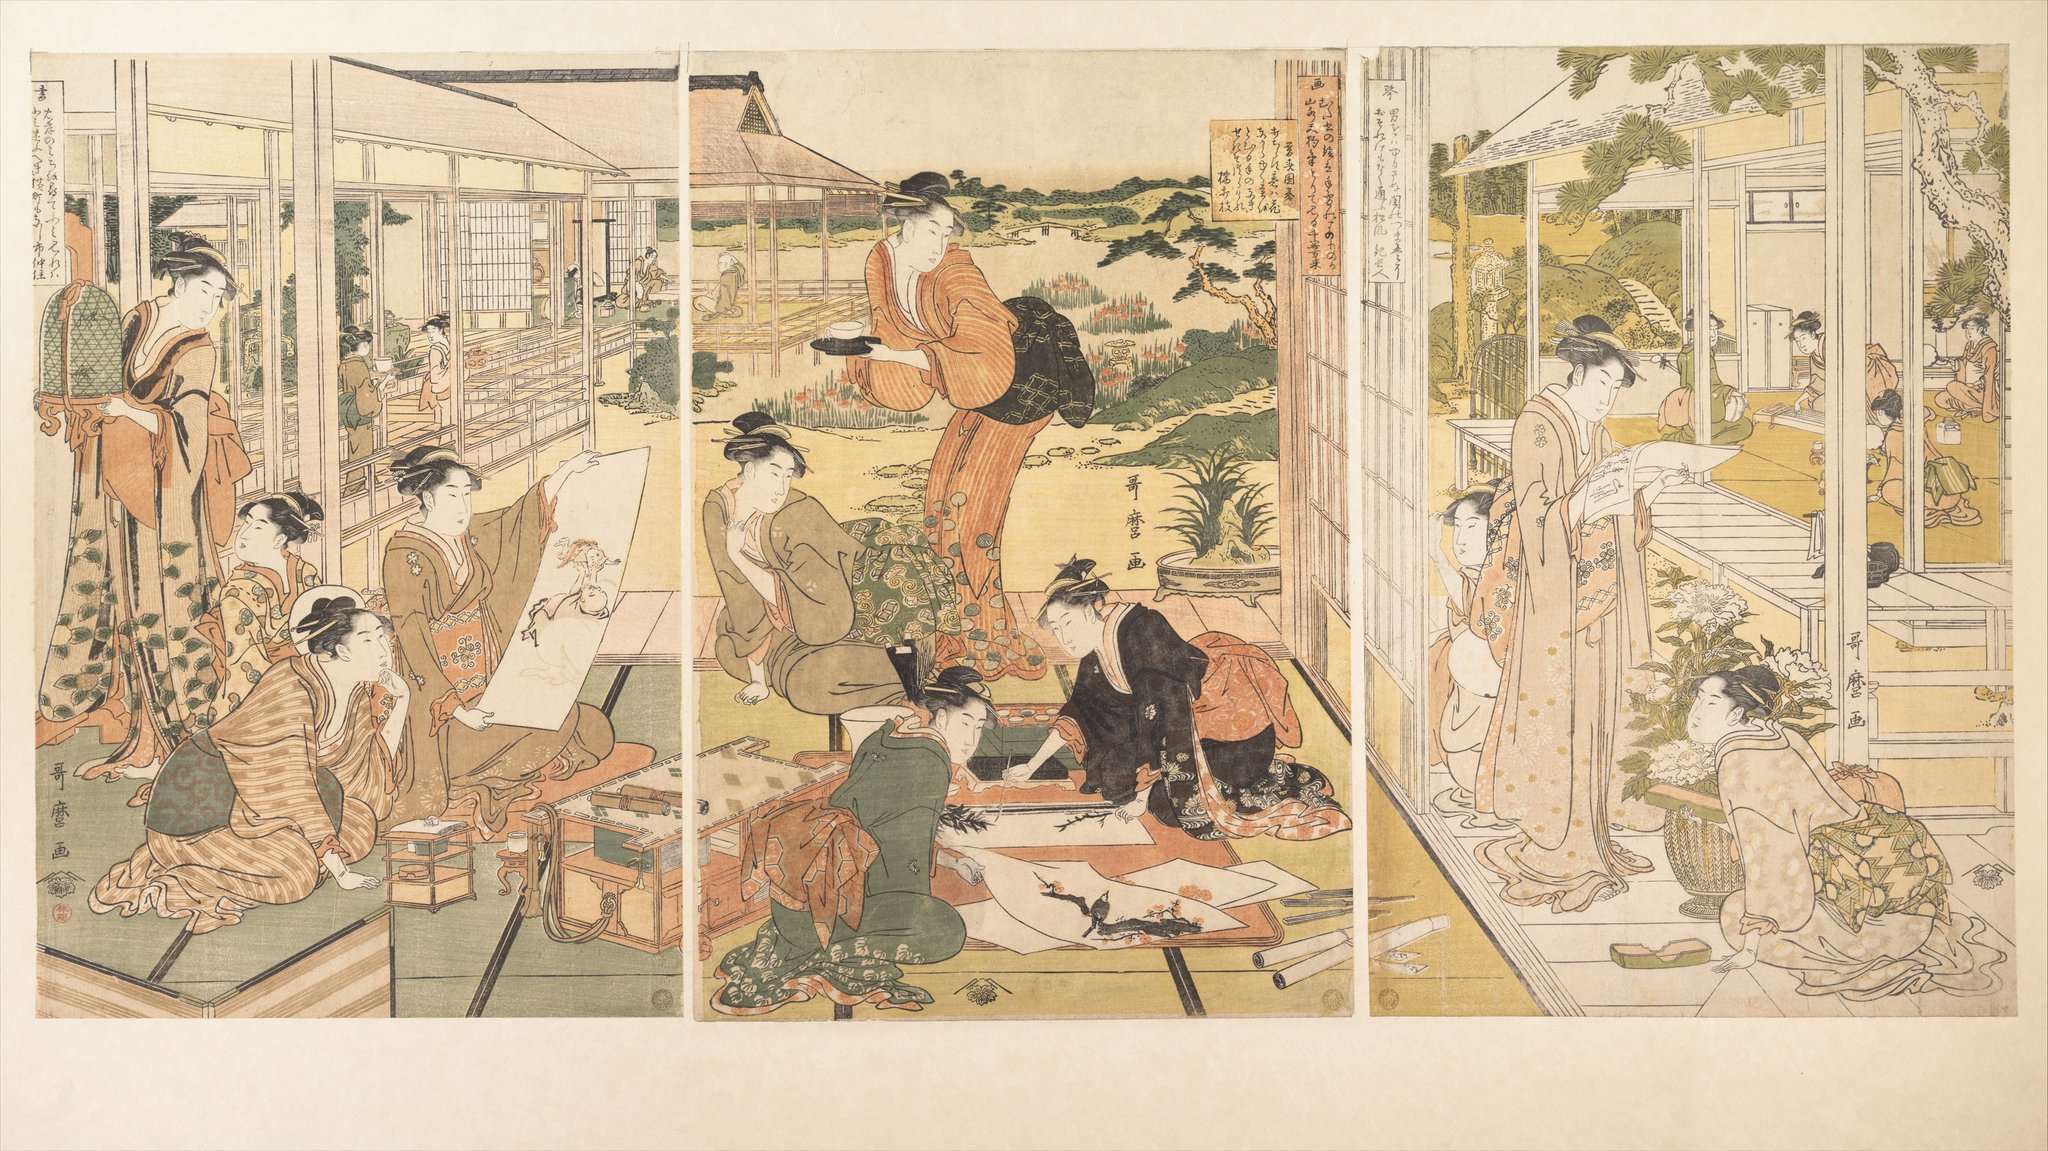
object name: print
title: The Four Accomplishments (Kinkishoga)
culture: japanese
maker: kitagawa utamaro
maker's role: artist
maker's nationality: japanese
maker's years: 1754-1806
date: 1788-1790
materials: ink, paper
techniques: woodblock print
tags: painting,houses,women